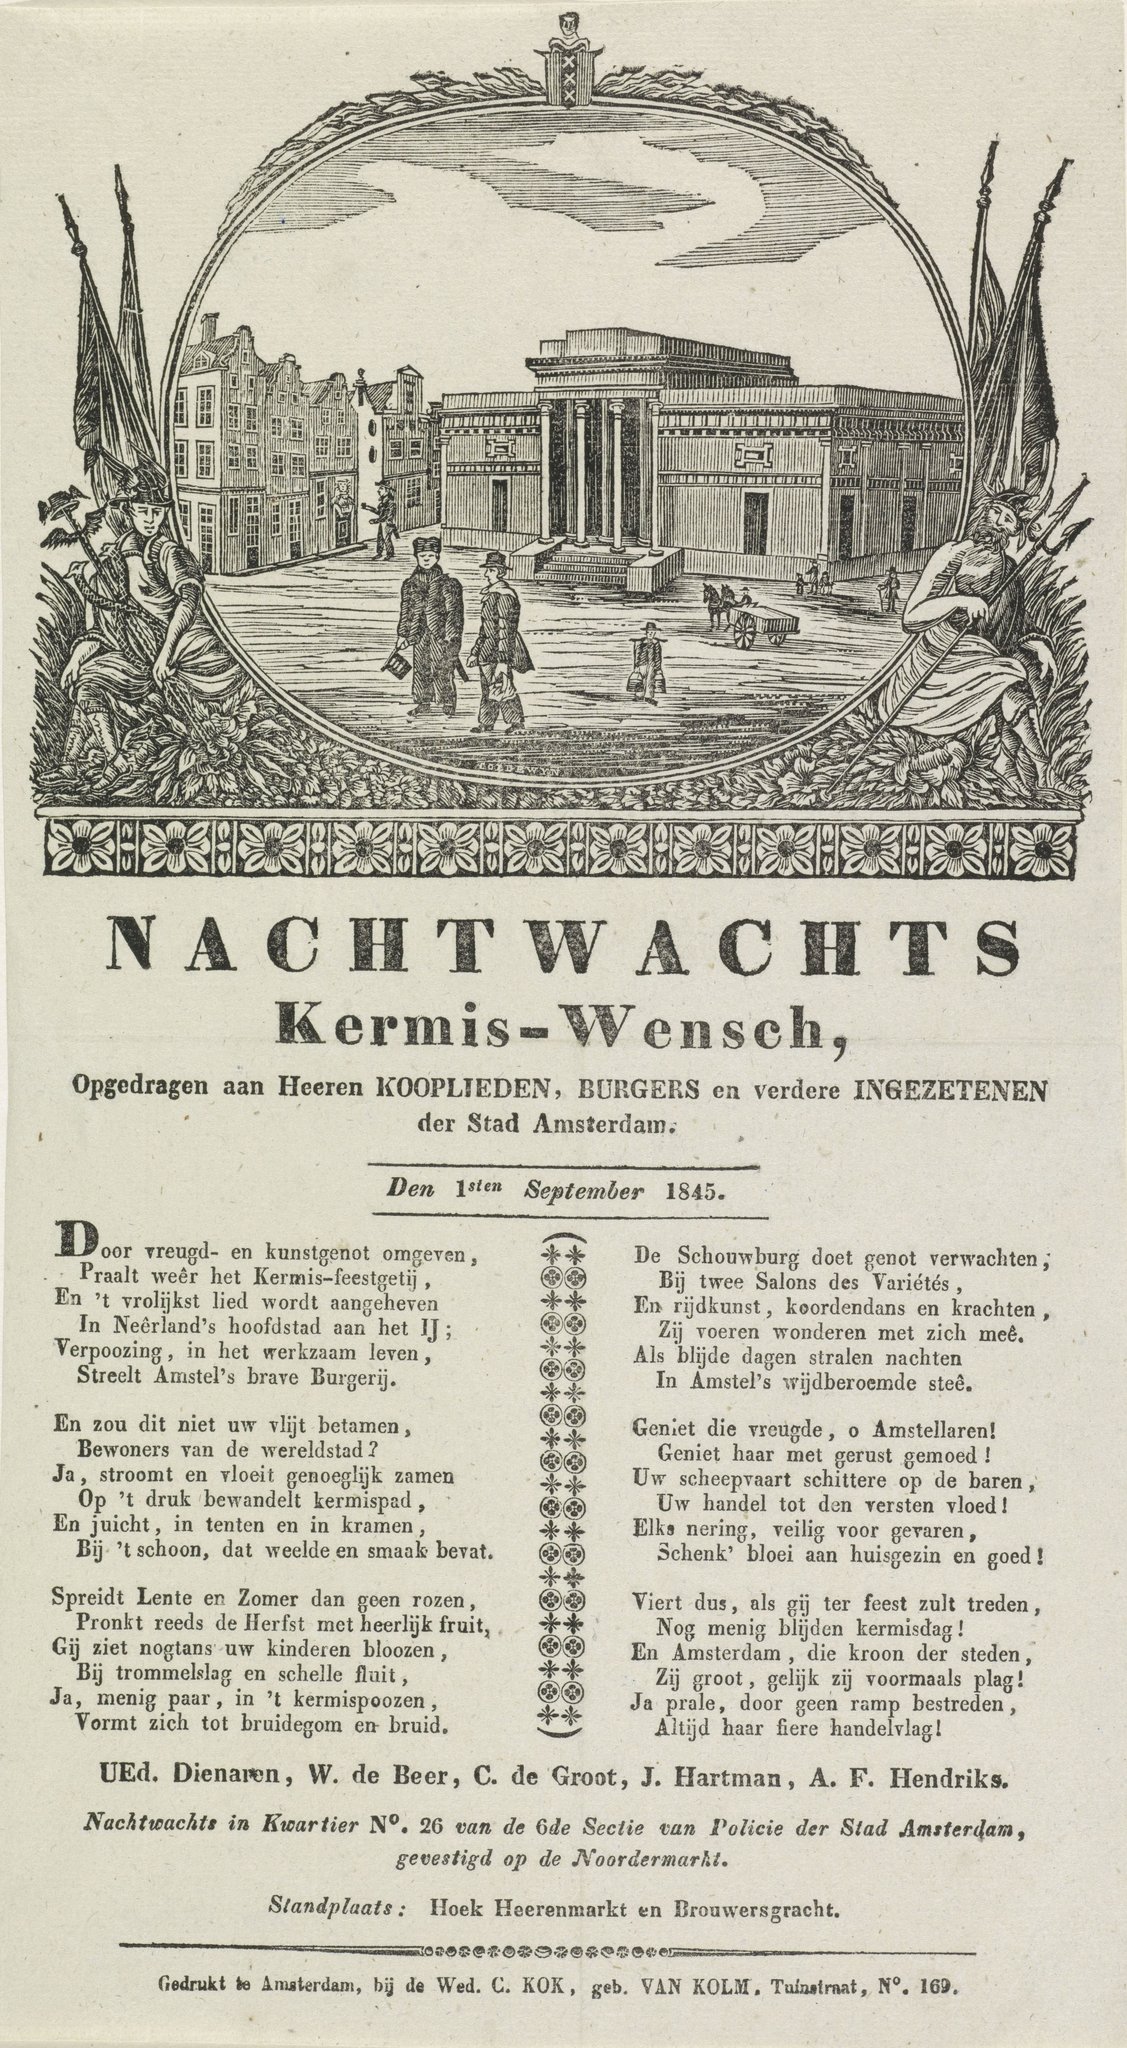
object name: print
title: Nachtwachts Kermis-Wensch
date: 1845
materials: paper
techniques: letterpress printing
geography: netherlands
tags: night patrol, amsterdam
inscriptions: collector's mark: Lugt 2228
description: Kermisprent van de Amsterdamse nachtwacht (ratelwacht), 1 september 1845. Enkele mannen lopen 's nachts met ratels door een straat voor de Beurs van Zocher. Ovale voorstelling met links de Vrijheid en rechts een riviergod. Met een vers in twee kolommen. Namens de nachtwacht in kwartier No. 26 van de 6e sectie van Politie: W. de Beer, C. de Groot, J. Hartman en A.F. Hendriks.